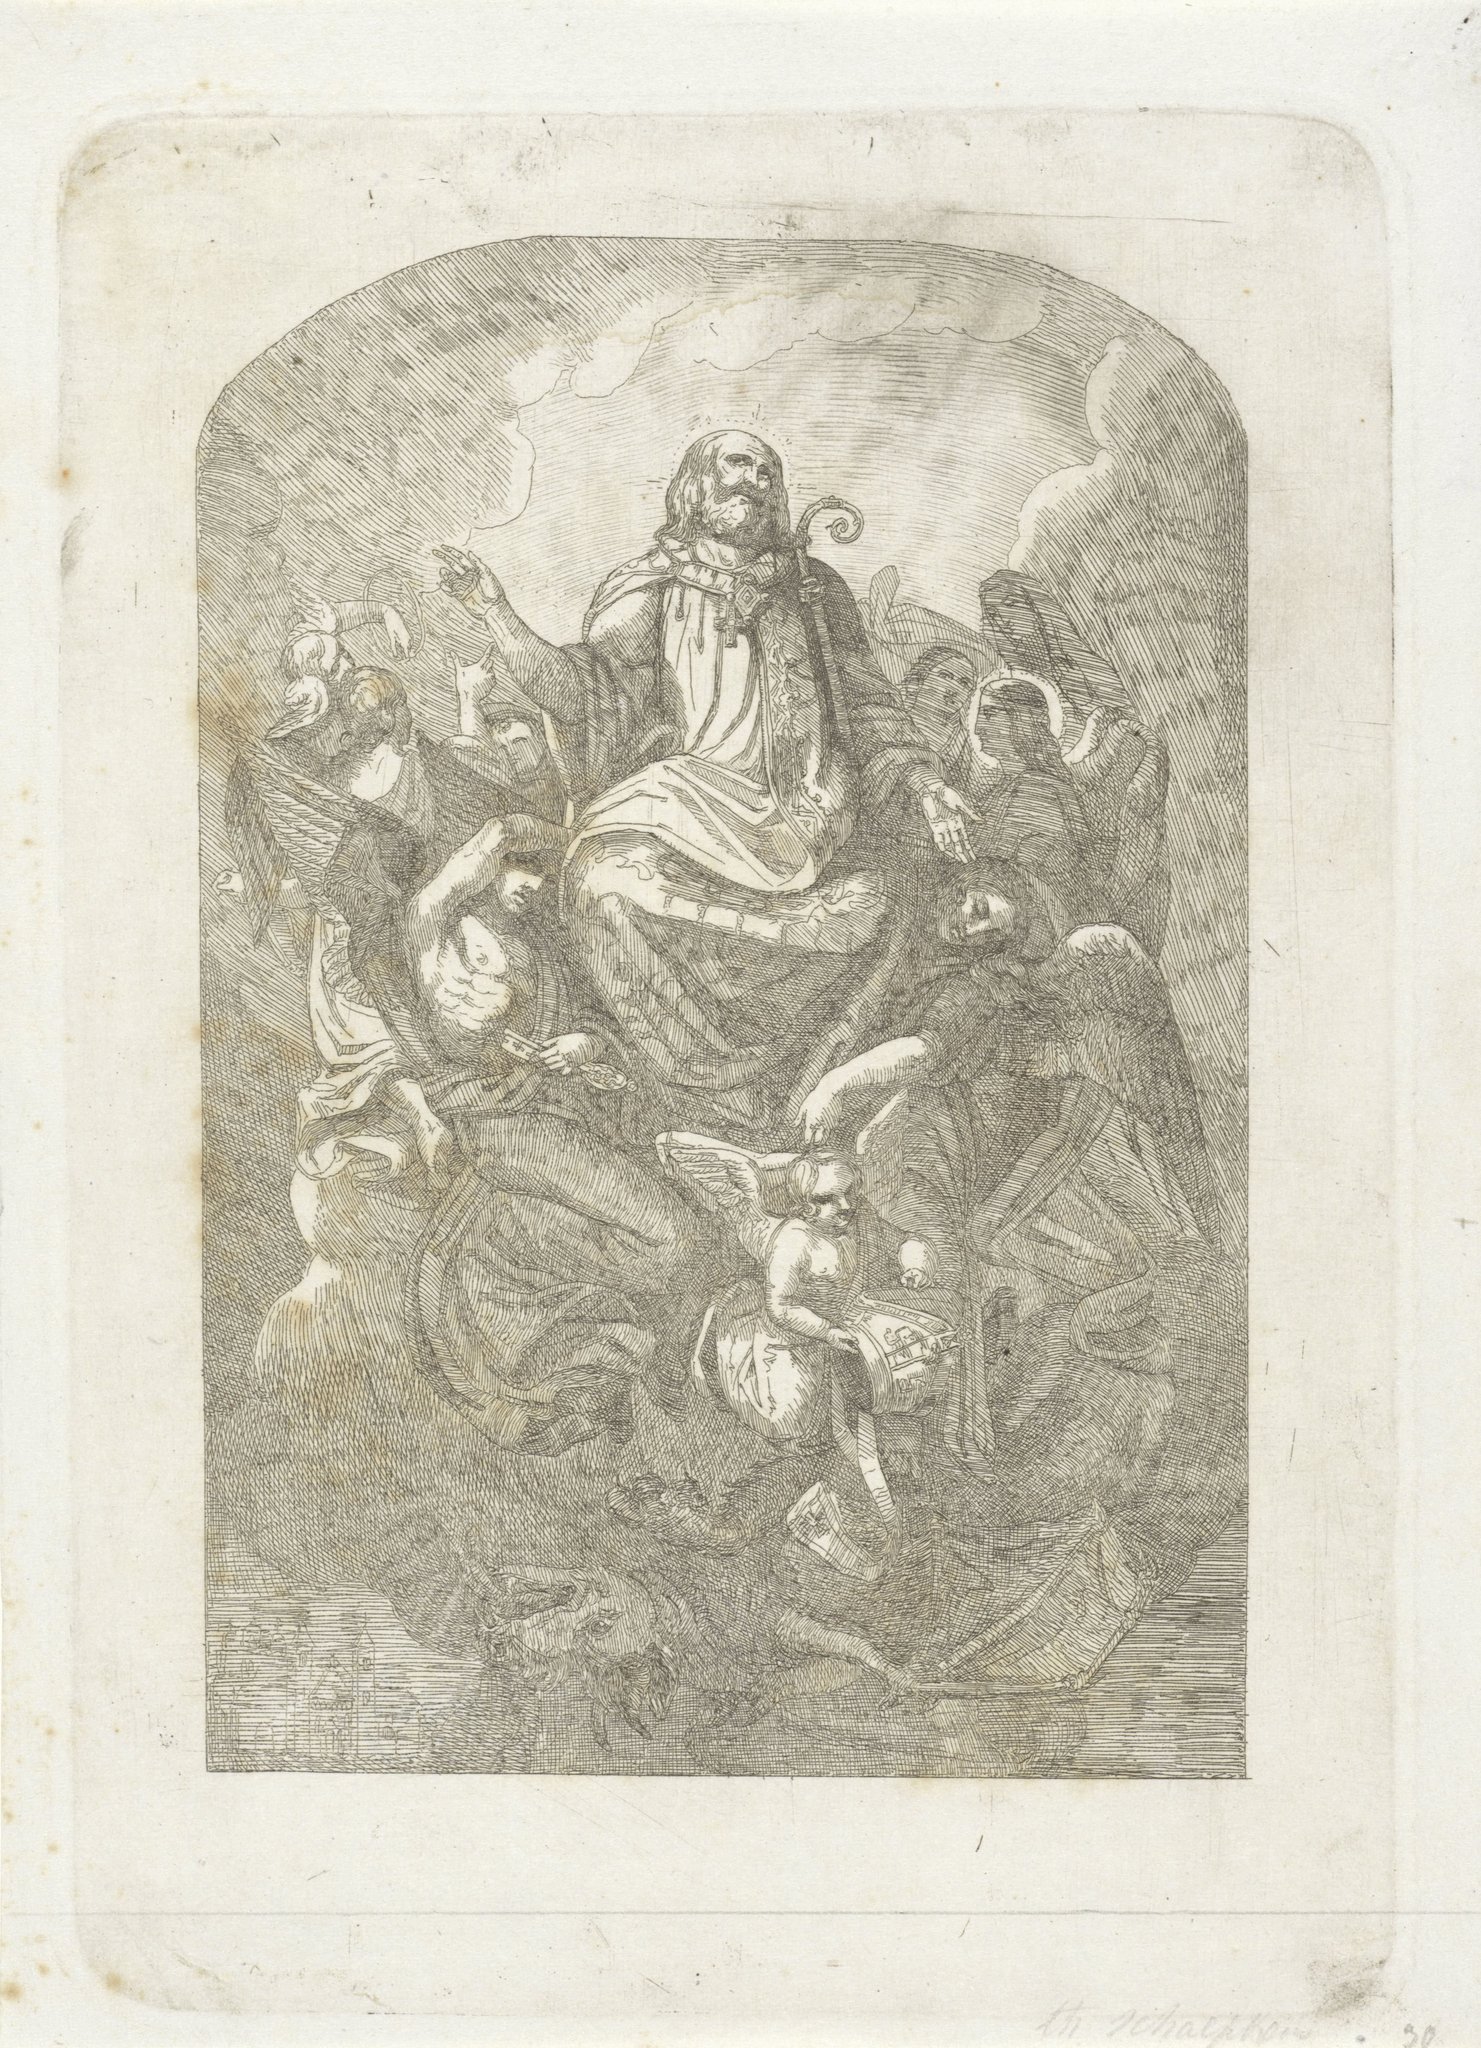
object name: print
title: Heilige Servatius van Maastricht door engelen ten hemel gedragen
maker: theodoor schaepkens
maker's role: draughtsman, print maker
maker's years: 1810-1883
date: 1837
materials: paper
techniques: etching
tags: servatius, bishop of tongeren and maastricht; possible attributes: clog (wooden shoe), dragon, eagle, key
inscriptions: collector's mark: Lugt 2228